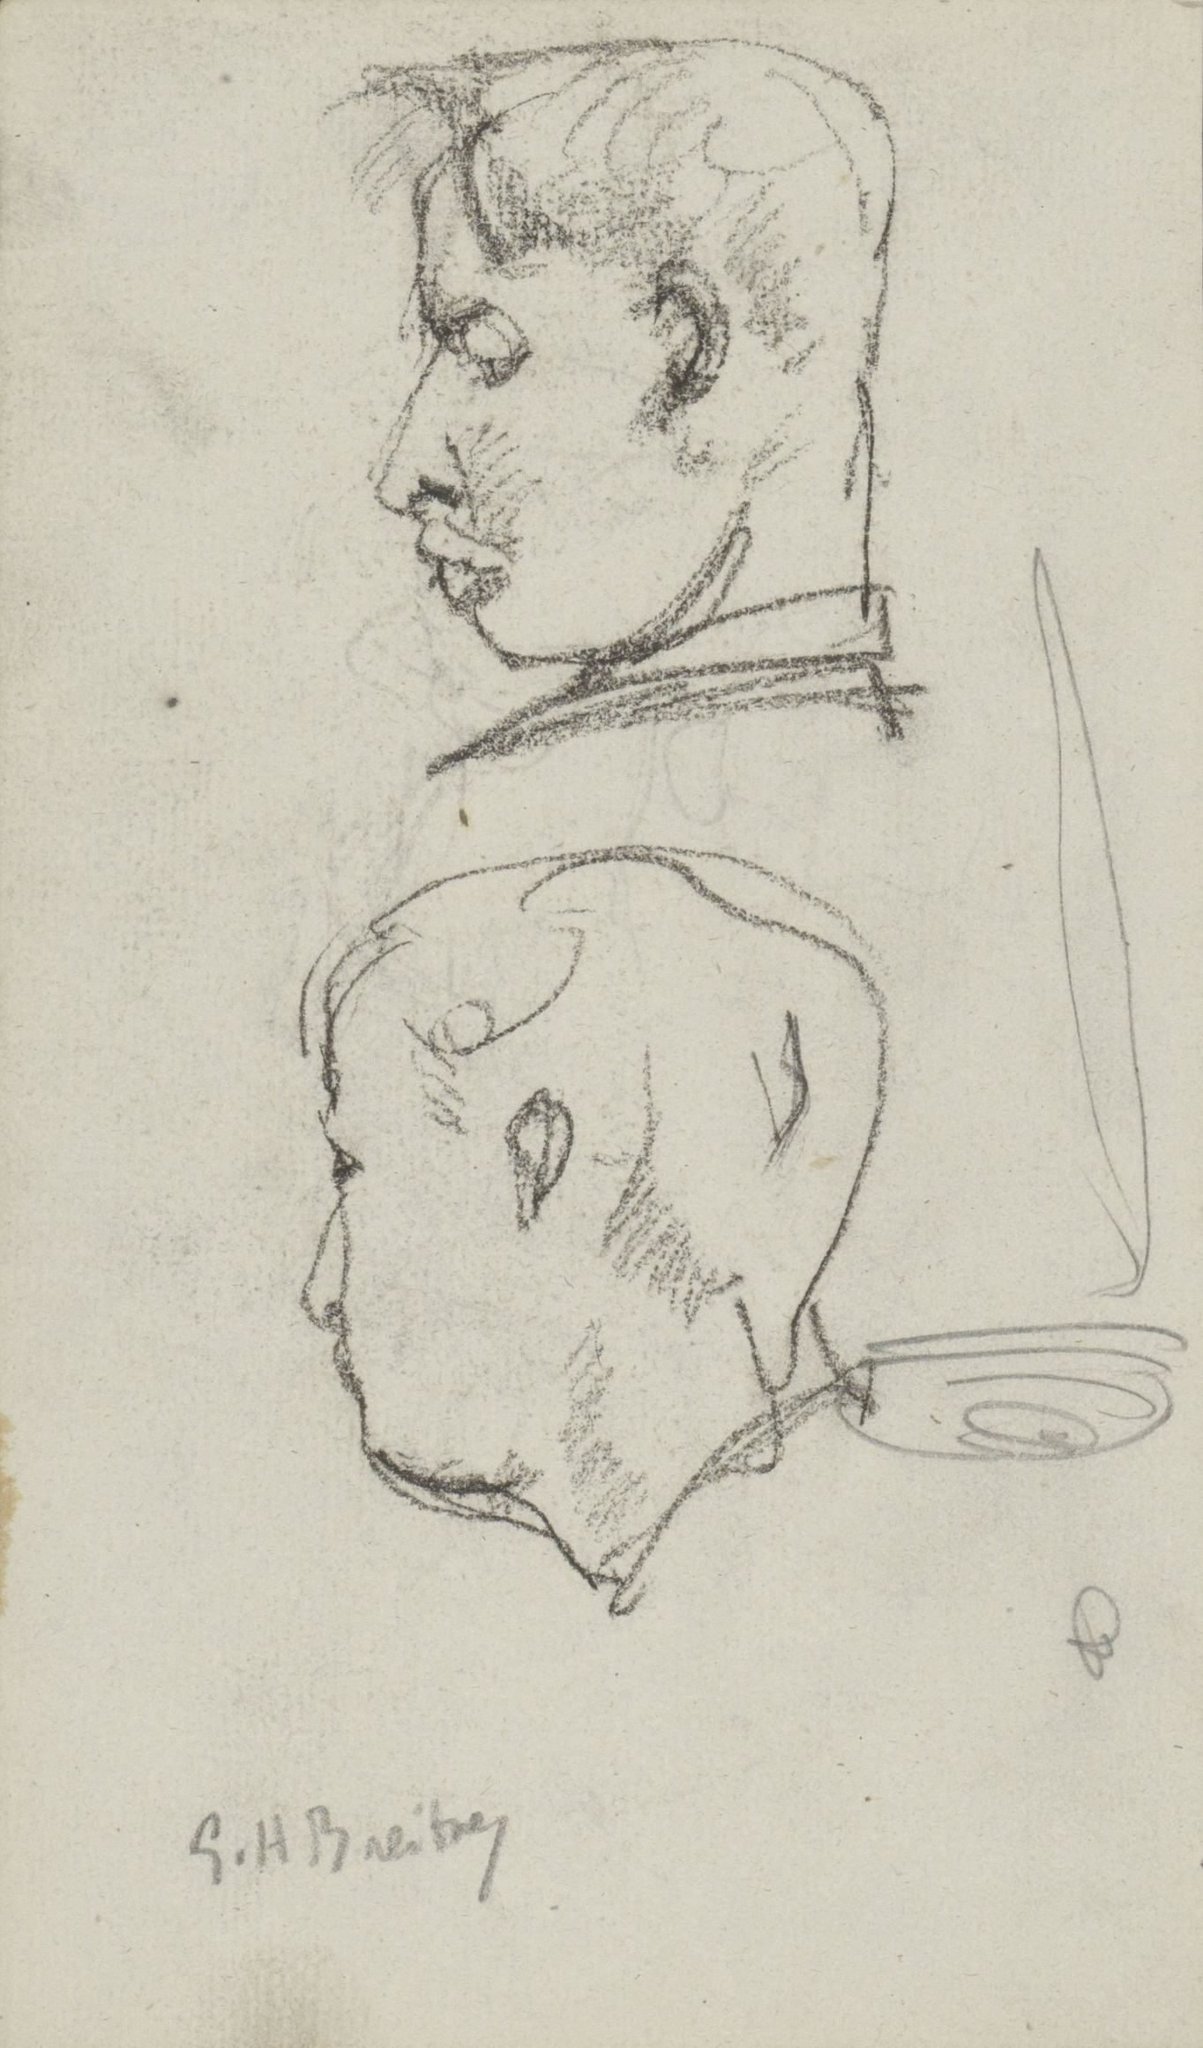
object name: drawing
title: Twee mannenhoofden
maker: george hendrik breitner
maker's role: draughtsman, painter, print maker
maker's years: 1857-1923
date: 1882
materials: chalk, paper, pencil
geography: rotterdam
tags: head (human)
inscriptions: signature: ‘G.H Breitner’